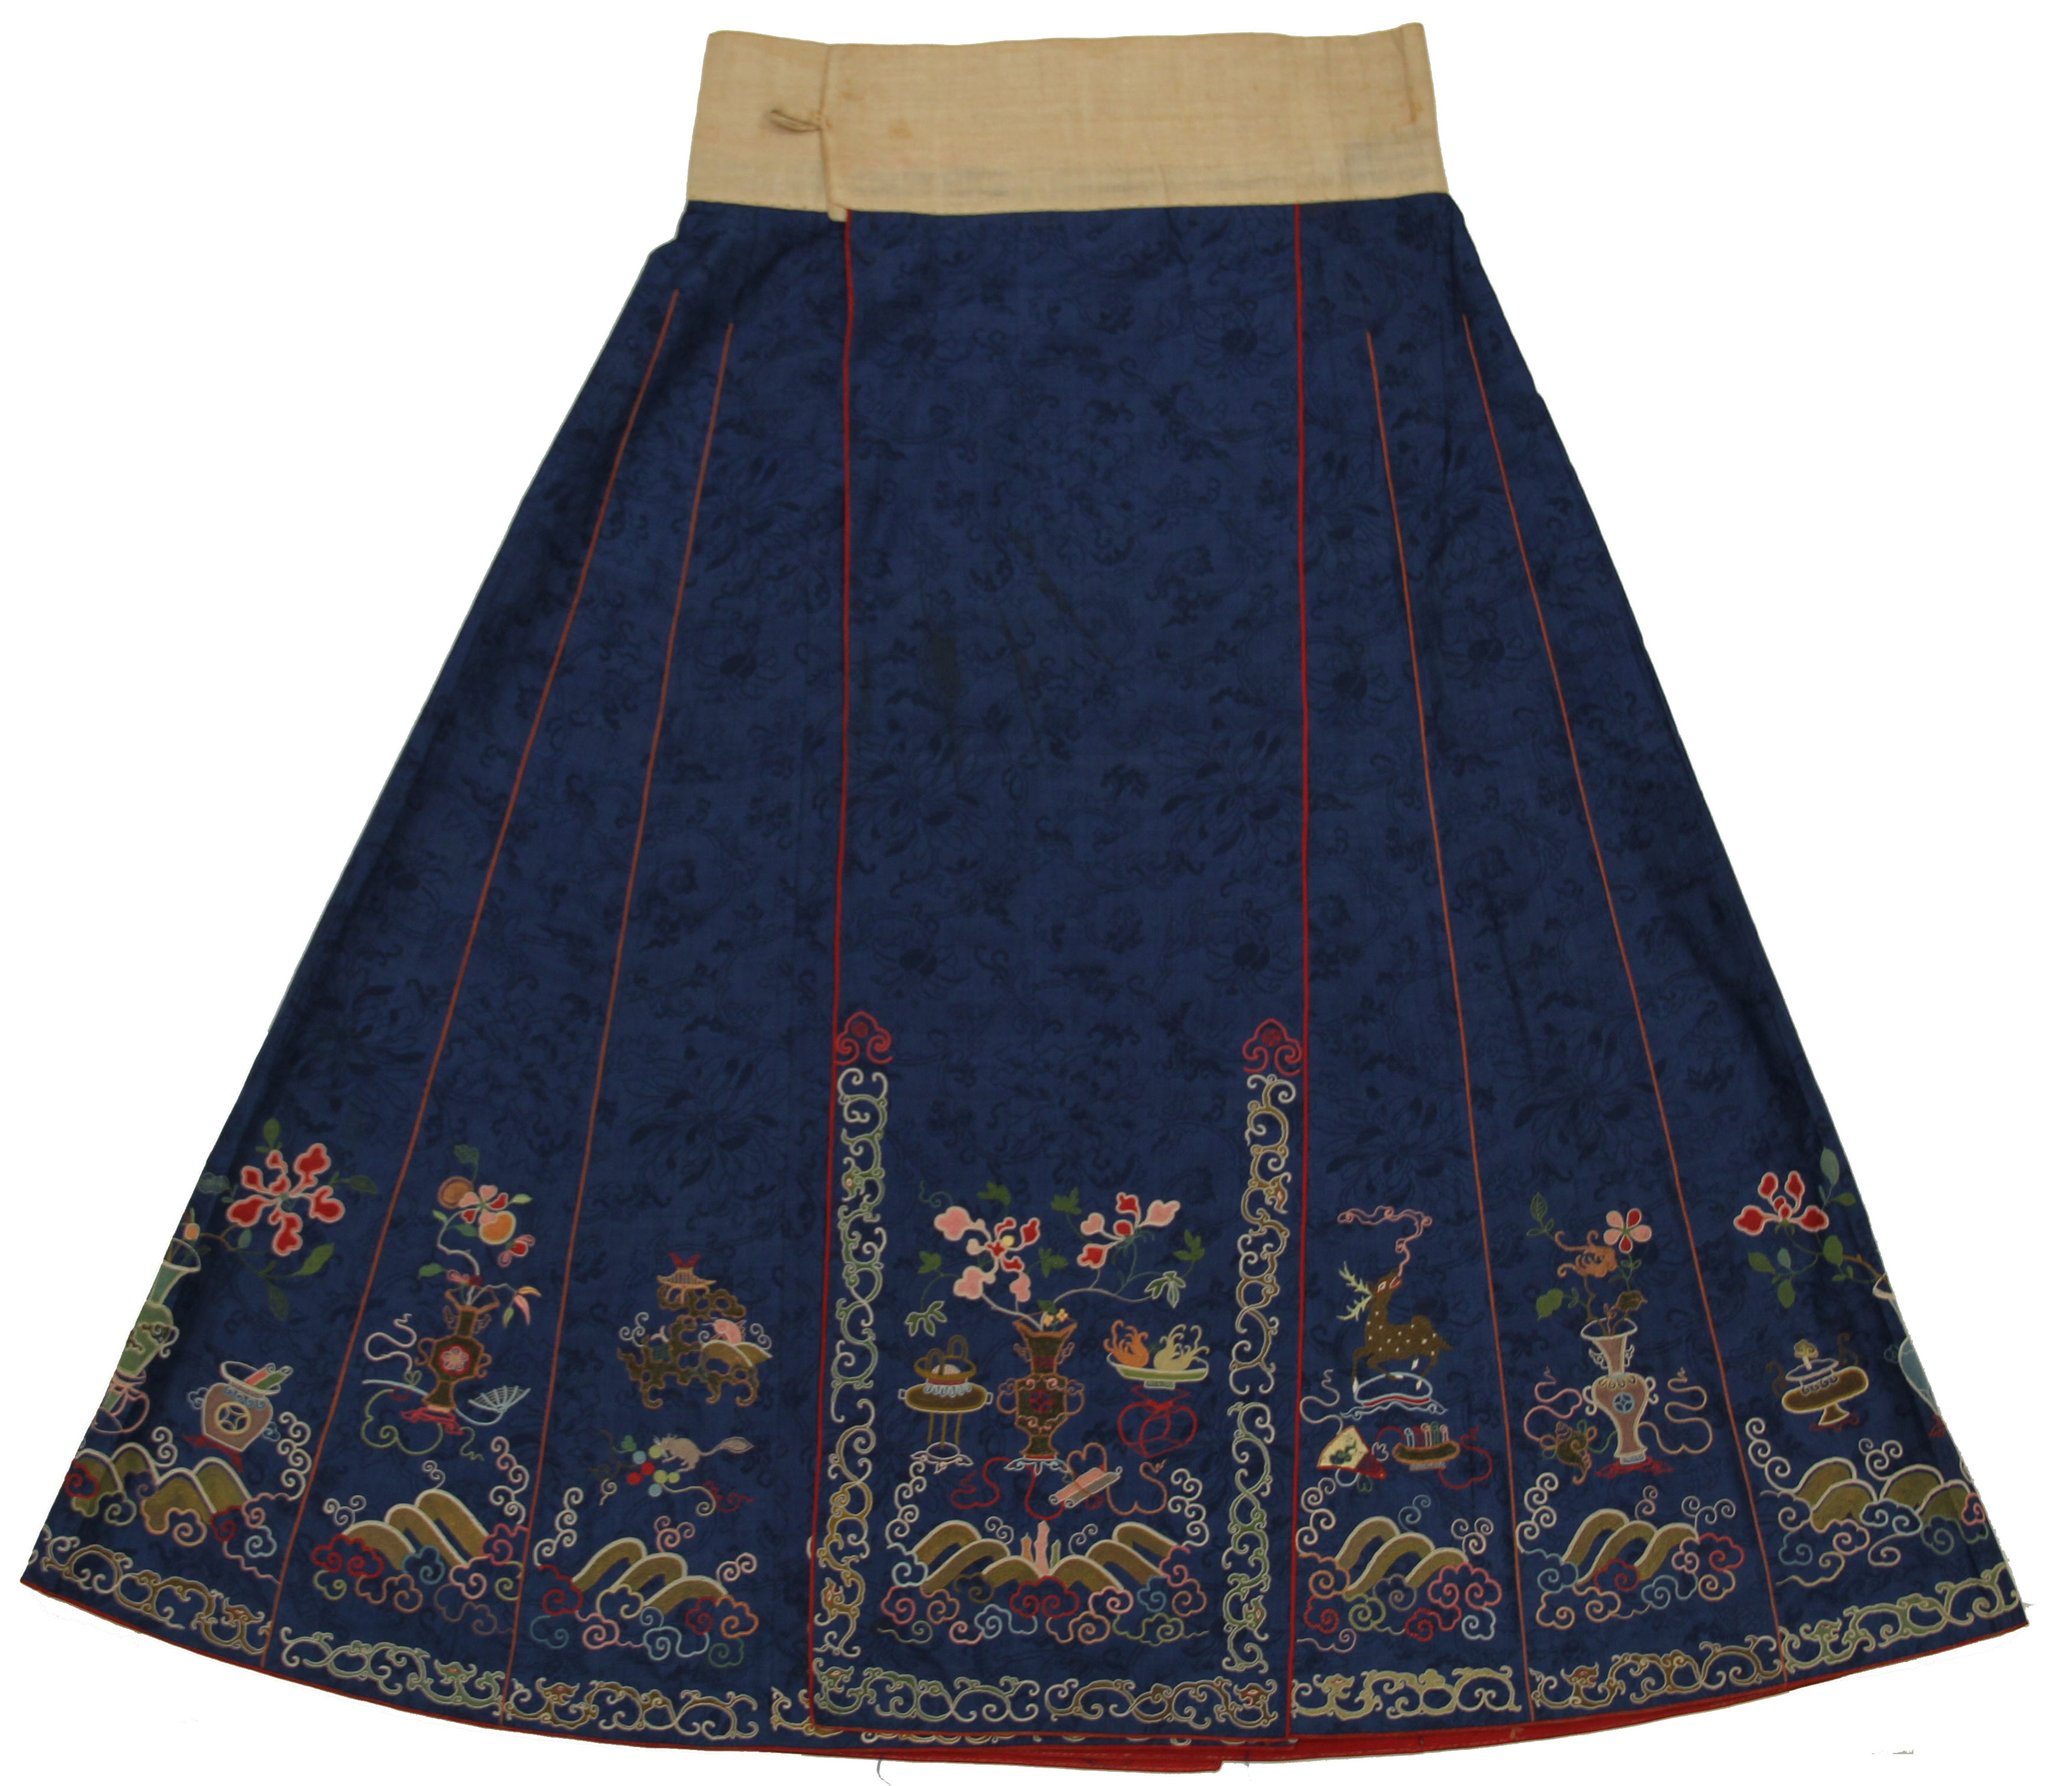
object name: skirt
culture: chinese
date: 1701-1800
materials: metal thread, silk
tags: deer,flowers